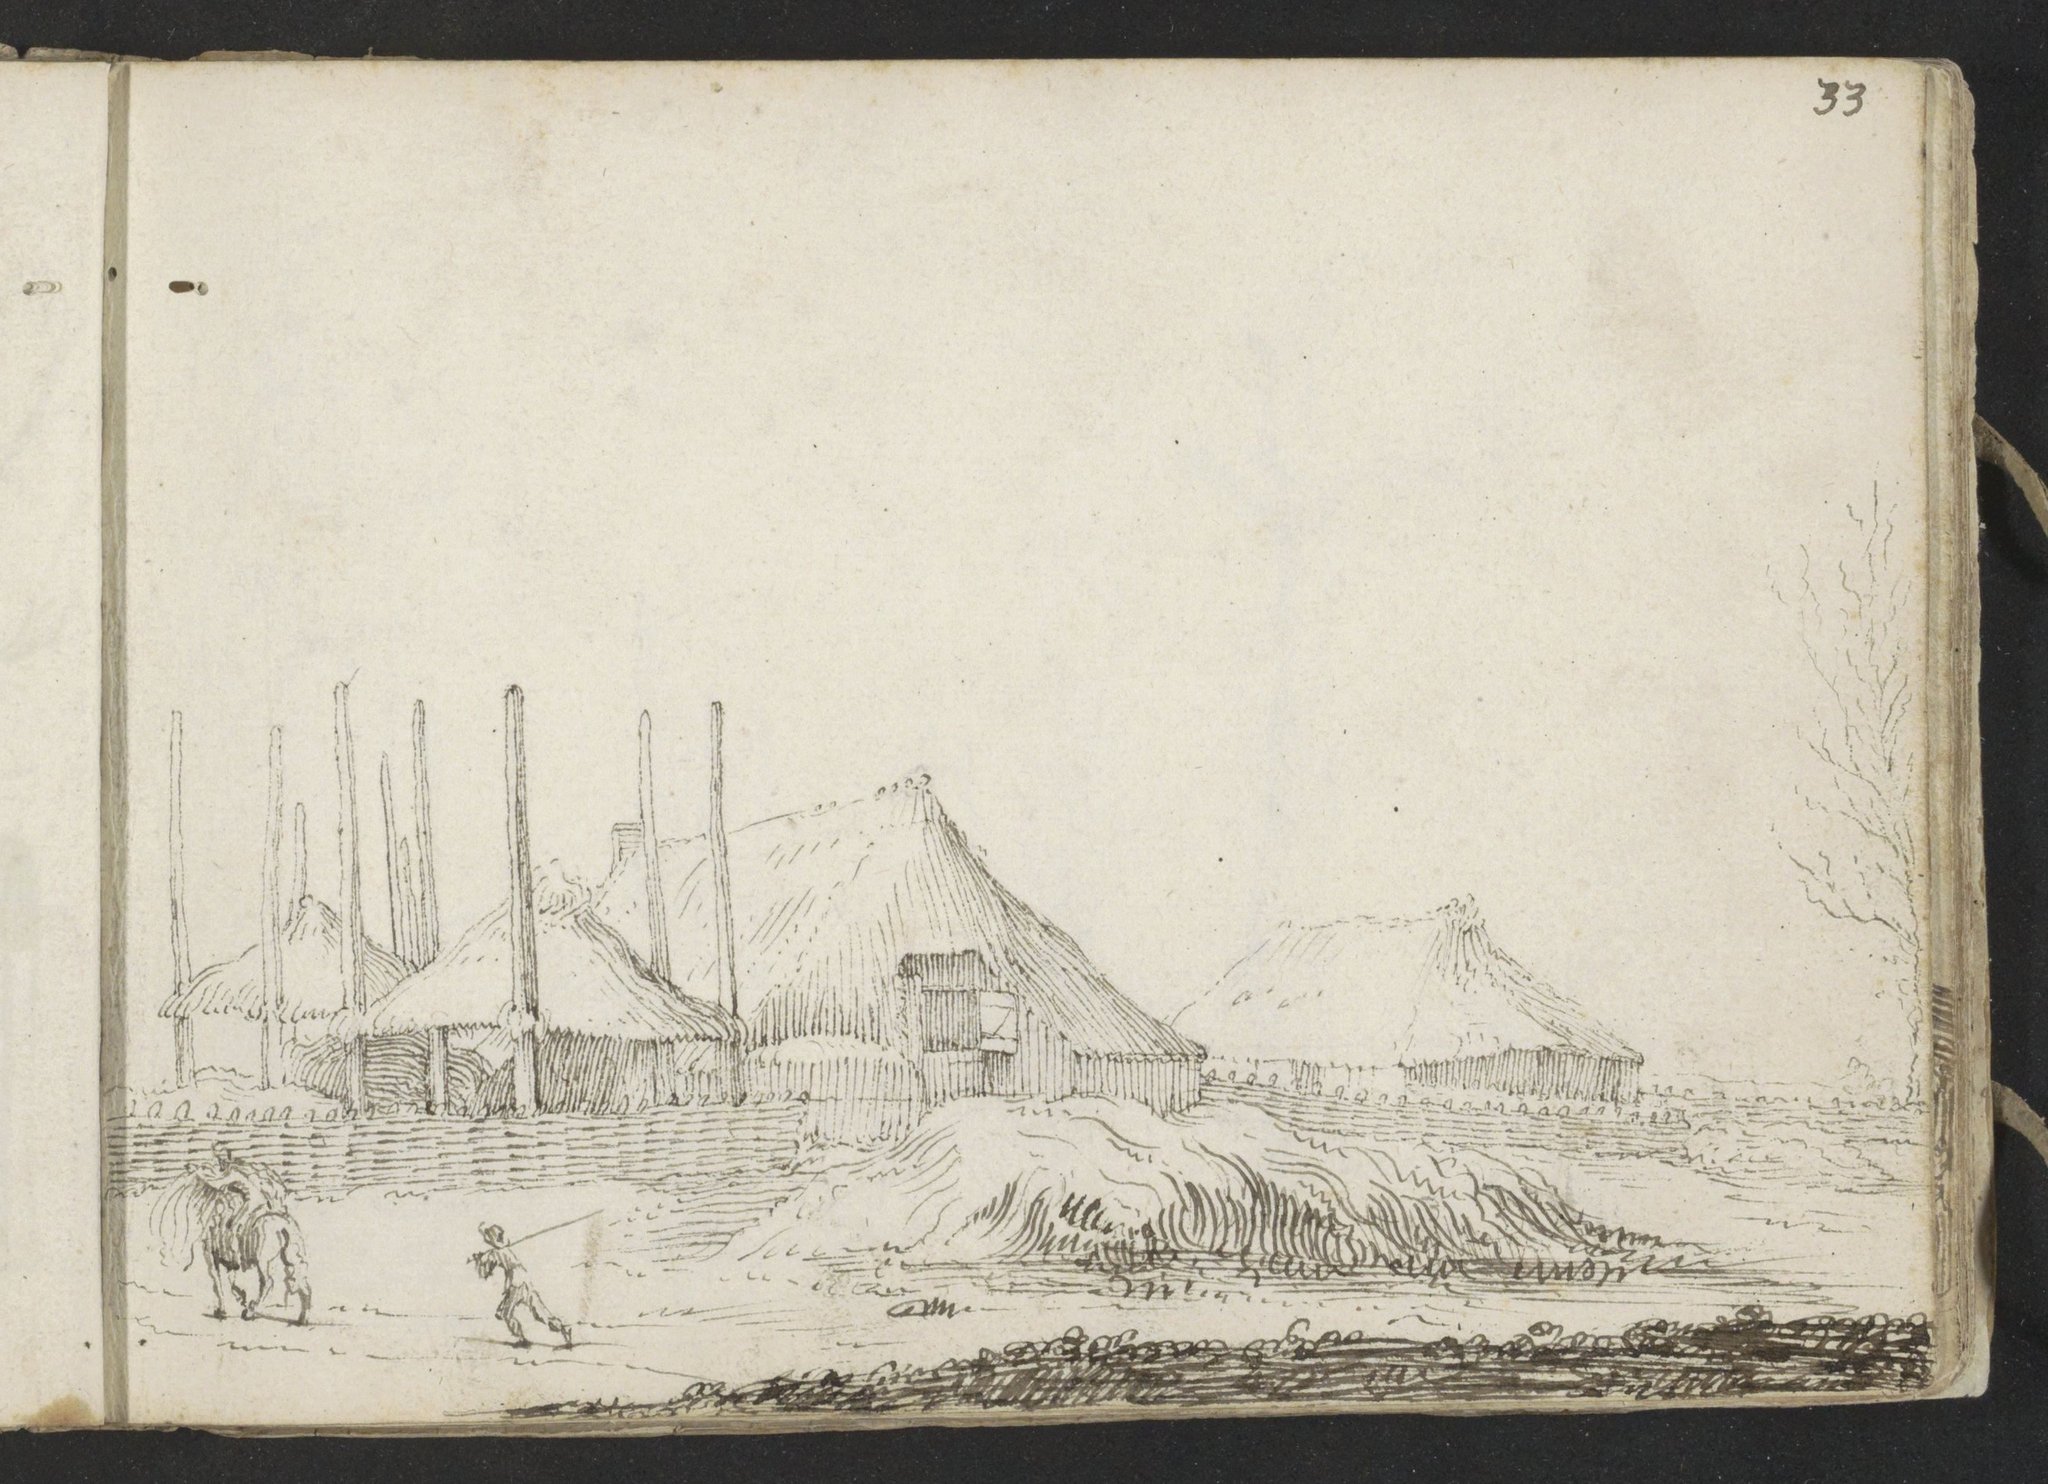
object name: sketchbook leaf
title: Omheinde boerderij met hooischuren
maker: gerard ter borch (ii)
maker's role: draughtsman, painter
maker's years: 1617-1681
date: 1631-1633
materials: ink, paper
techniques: pen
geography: zwolle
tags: riding a horse, ass, or mule; rider, horseman, fence, wall, paling, hay-stack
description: Buiten de omheining een ruiter en een jongen met een stok. Blad 33 recto uit een schetsboek met 55 bladen.